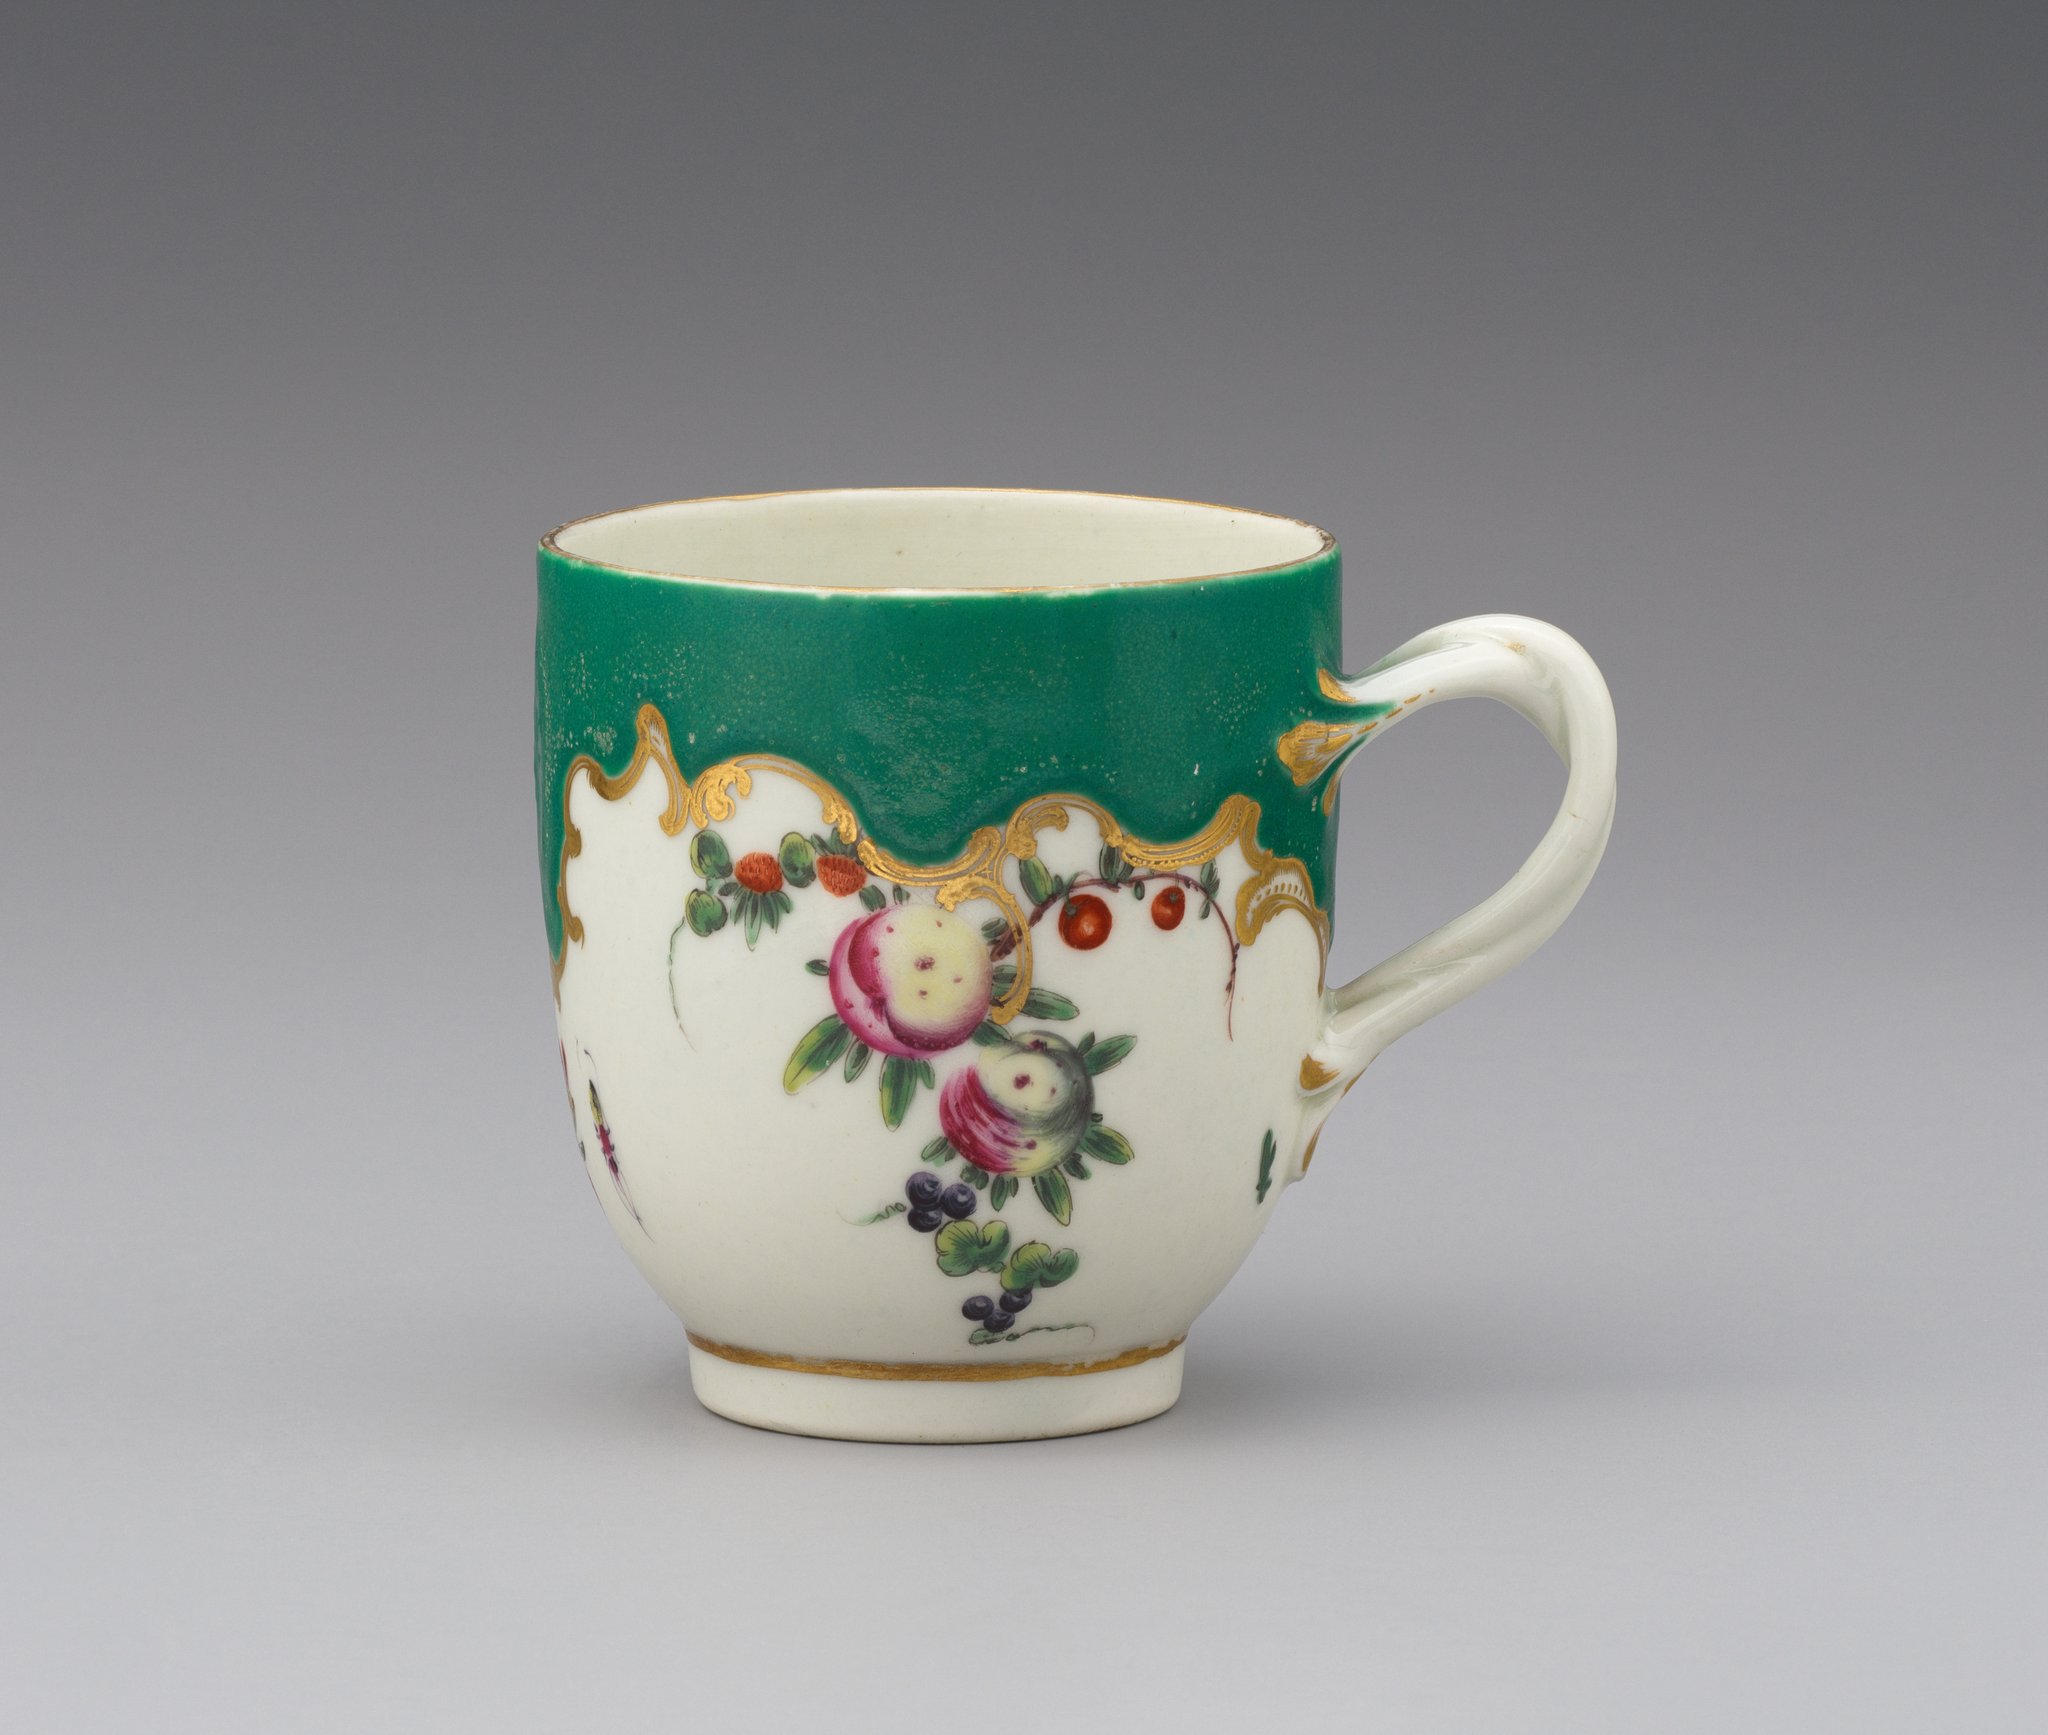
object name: cup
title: Cup (part of a service)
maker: worcester factory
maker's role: factory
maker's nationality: british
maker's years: 1751-2008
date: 1770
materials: soft paste porcelain